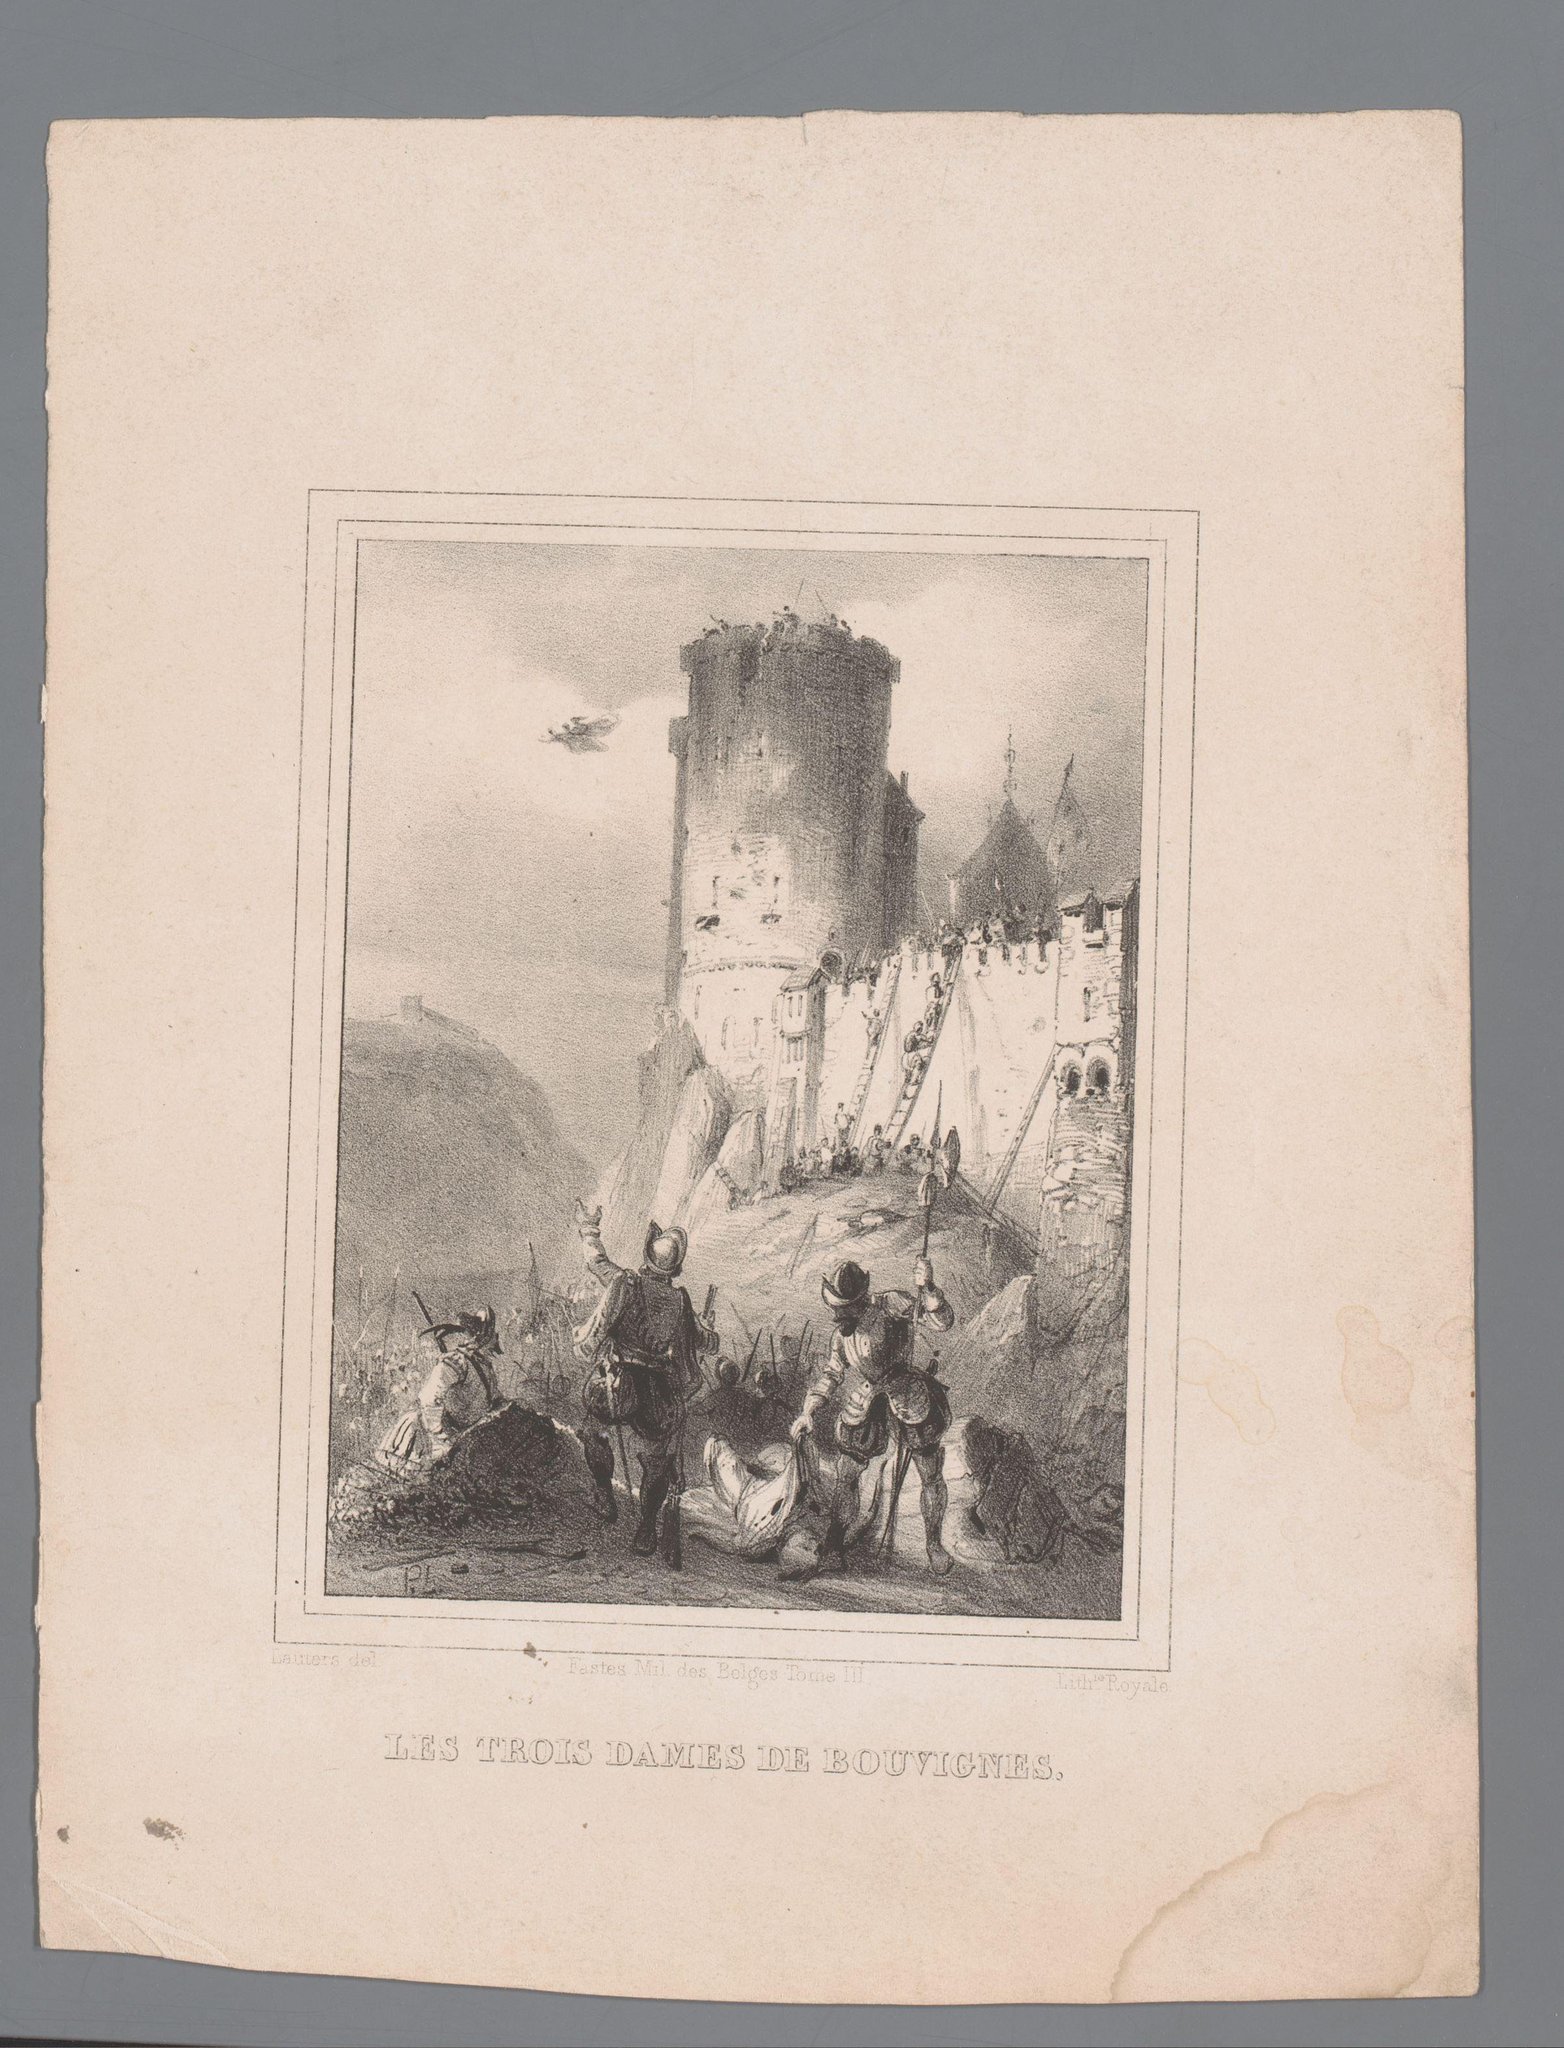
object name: book illustration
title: Les trois dames de Bouvignes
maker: paulus lauters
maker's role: print maker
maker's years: 1806-1875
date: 1835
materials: paper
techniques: lithograph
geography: brussels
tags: horrors of war, destruction of conquered city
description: De belegering van de stad Bouvignes in 1554 door de troepen van Hendrik II van Frankrijk. Op de achtergrond drie vrouwen die zich van een toren storten: dit zijn de drie "Dames van Crèvecoeur" die volgens de legende op die manier aan de aanval wilden ontsnappen.